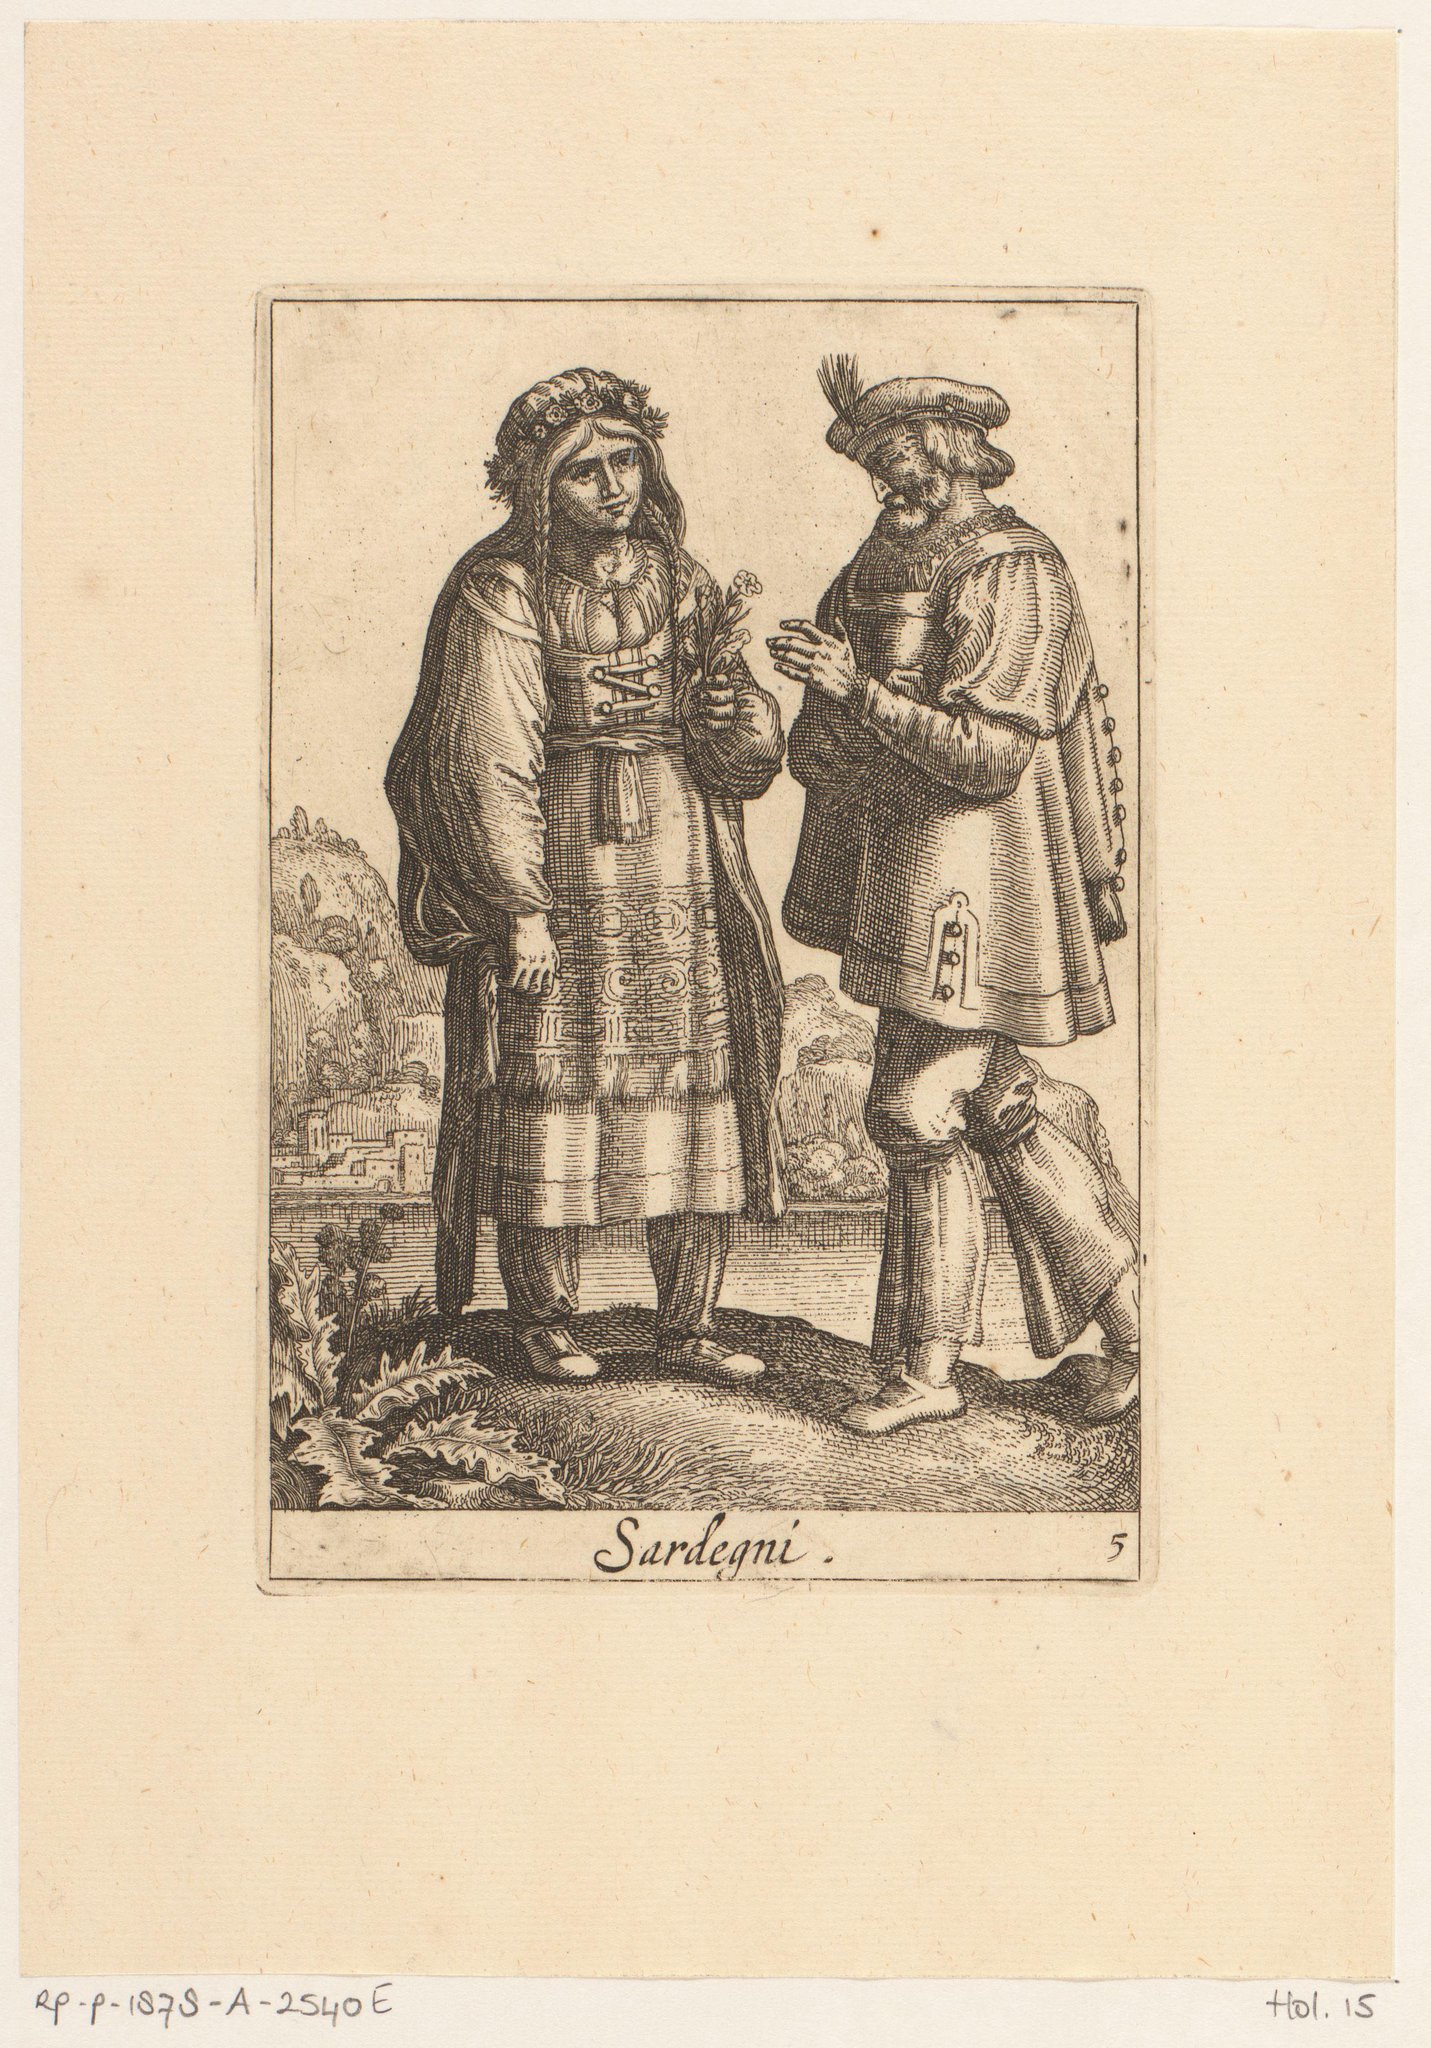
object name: print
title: Paar gekleed volgens de Sardiniaanse mode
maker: Anonymous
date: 1720-1772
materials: paper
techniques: etching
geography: amsterdam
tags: europeans (with name) (+ costume)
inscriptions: collector's mark: Lugt 2228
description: Landschap met paar, gekleed in mode uit Sardinië, Italië. Het paar is naar elkaar gedraaid en ten voeten uit weergegeven. De vrouw draagt een wollen japon en een met bloemen versierde muts, in haar handen houdt ze eveneens bloemen vast. De man draagt een tabbaard en een gepluimde baret. De prent maakt deel uit van een twaalfdelige serie prenten met Italiaanse kostuums.